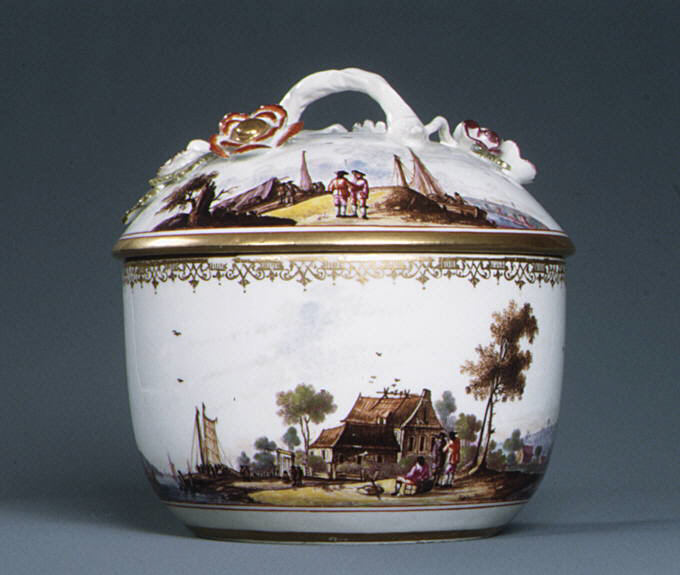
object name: sugar bowl with cover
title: Sugar bowl with cover (part of a service)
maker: meissen manufactory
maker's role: manufactory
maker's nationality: german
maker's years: 1710-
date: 1701-1800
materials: hard paste porcelain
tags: houses,trees,boats